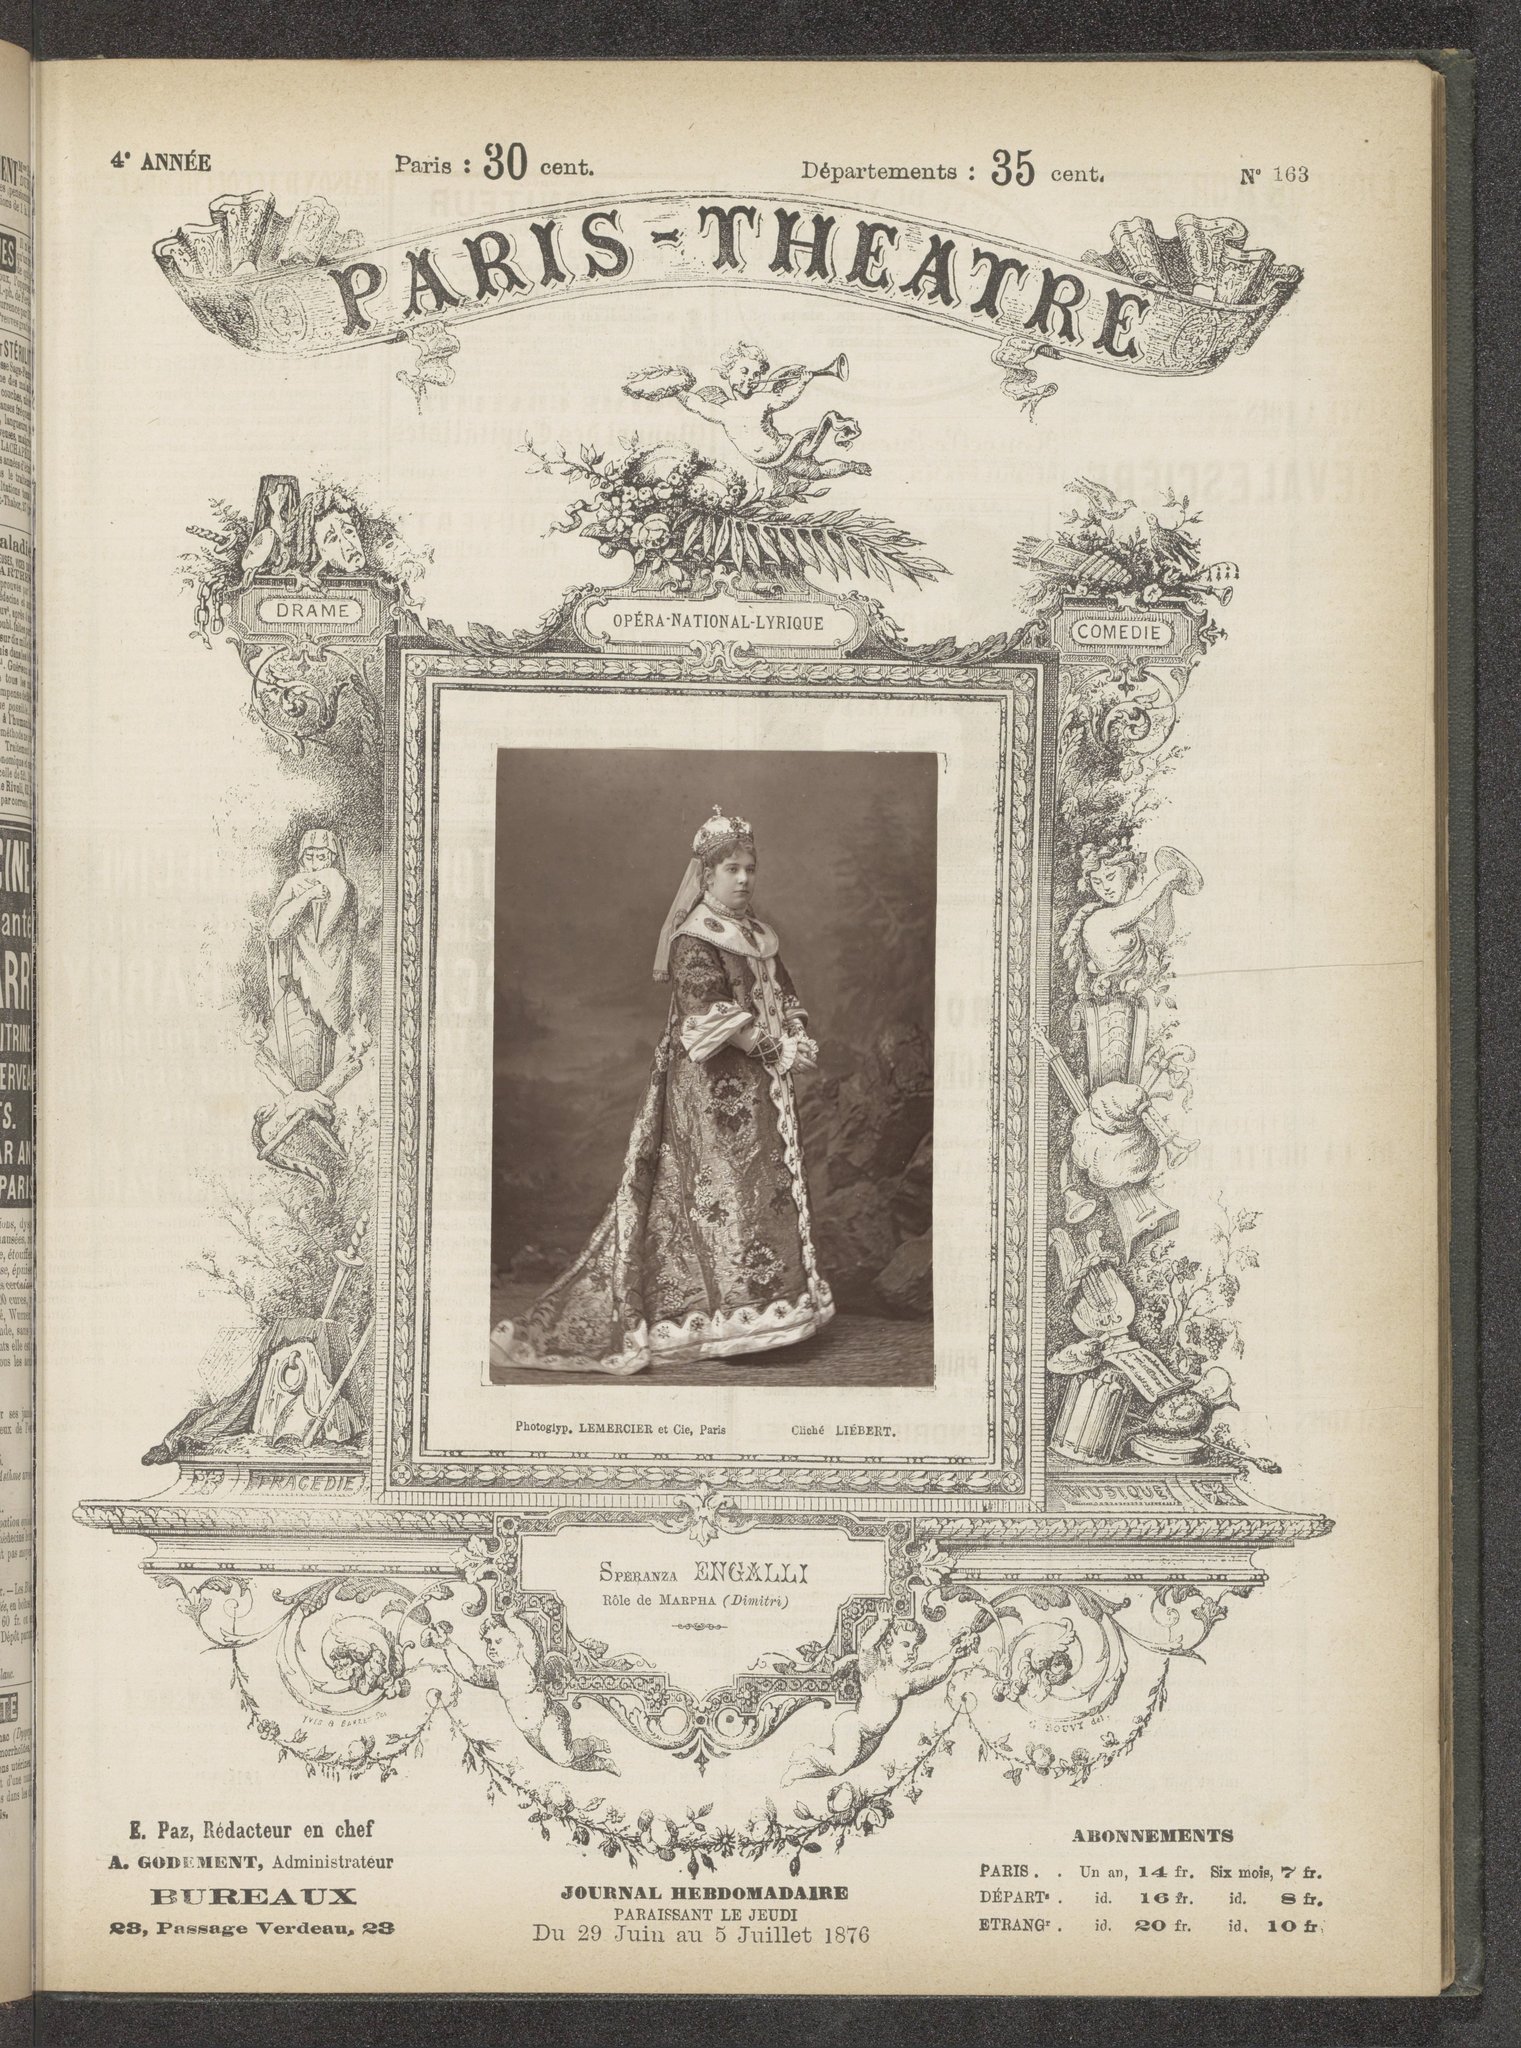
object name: page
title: Speranza Engalli rôle de Marpha (Dimitri)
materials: paper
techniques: woodburytype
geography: france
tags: portrait of actor, actress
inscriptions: number: ‘No 163’, inscription: ‘Journal hebdomadaire paraissant le jeudi Du 29 Juin au 5 Juillet 1876’